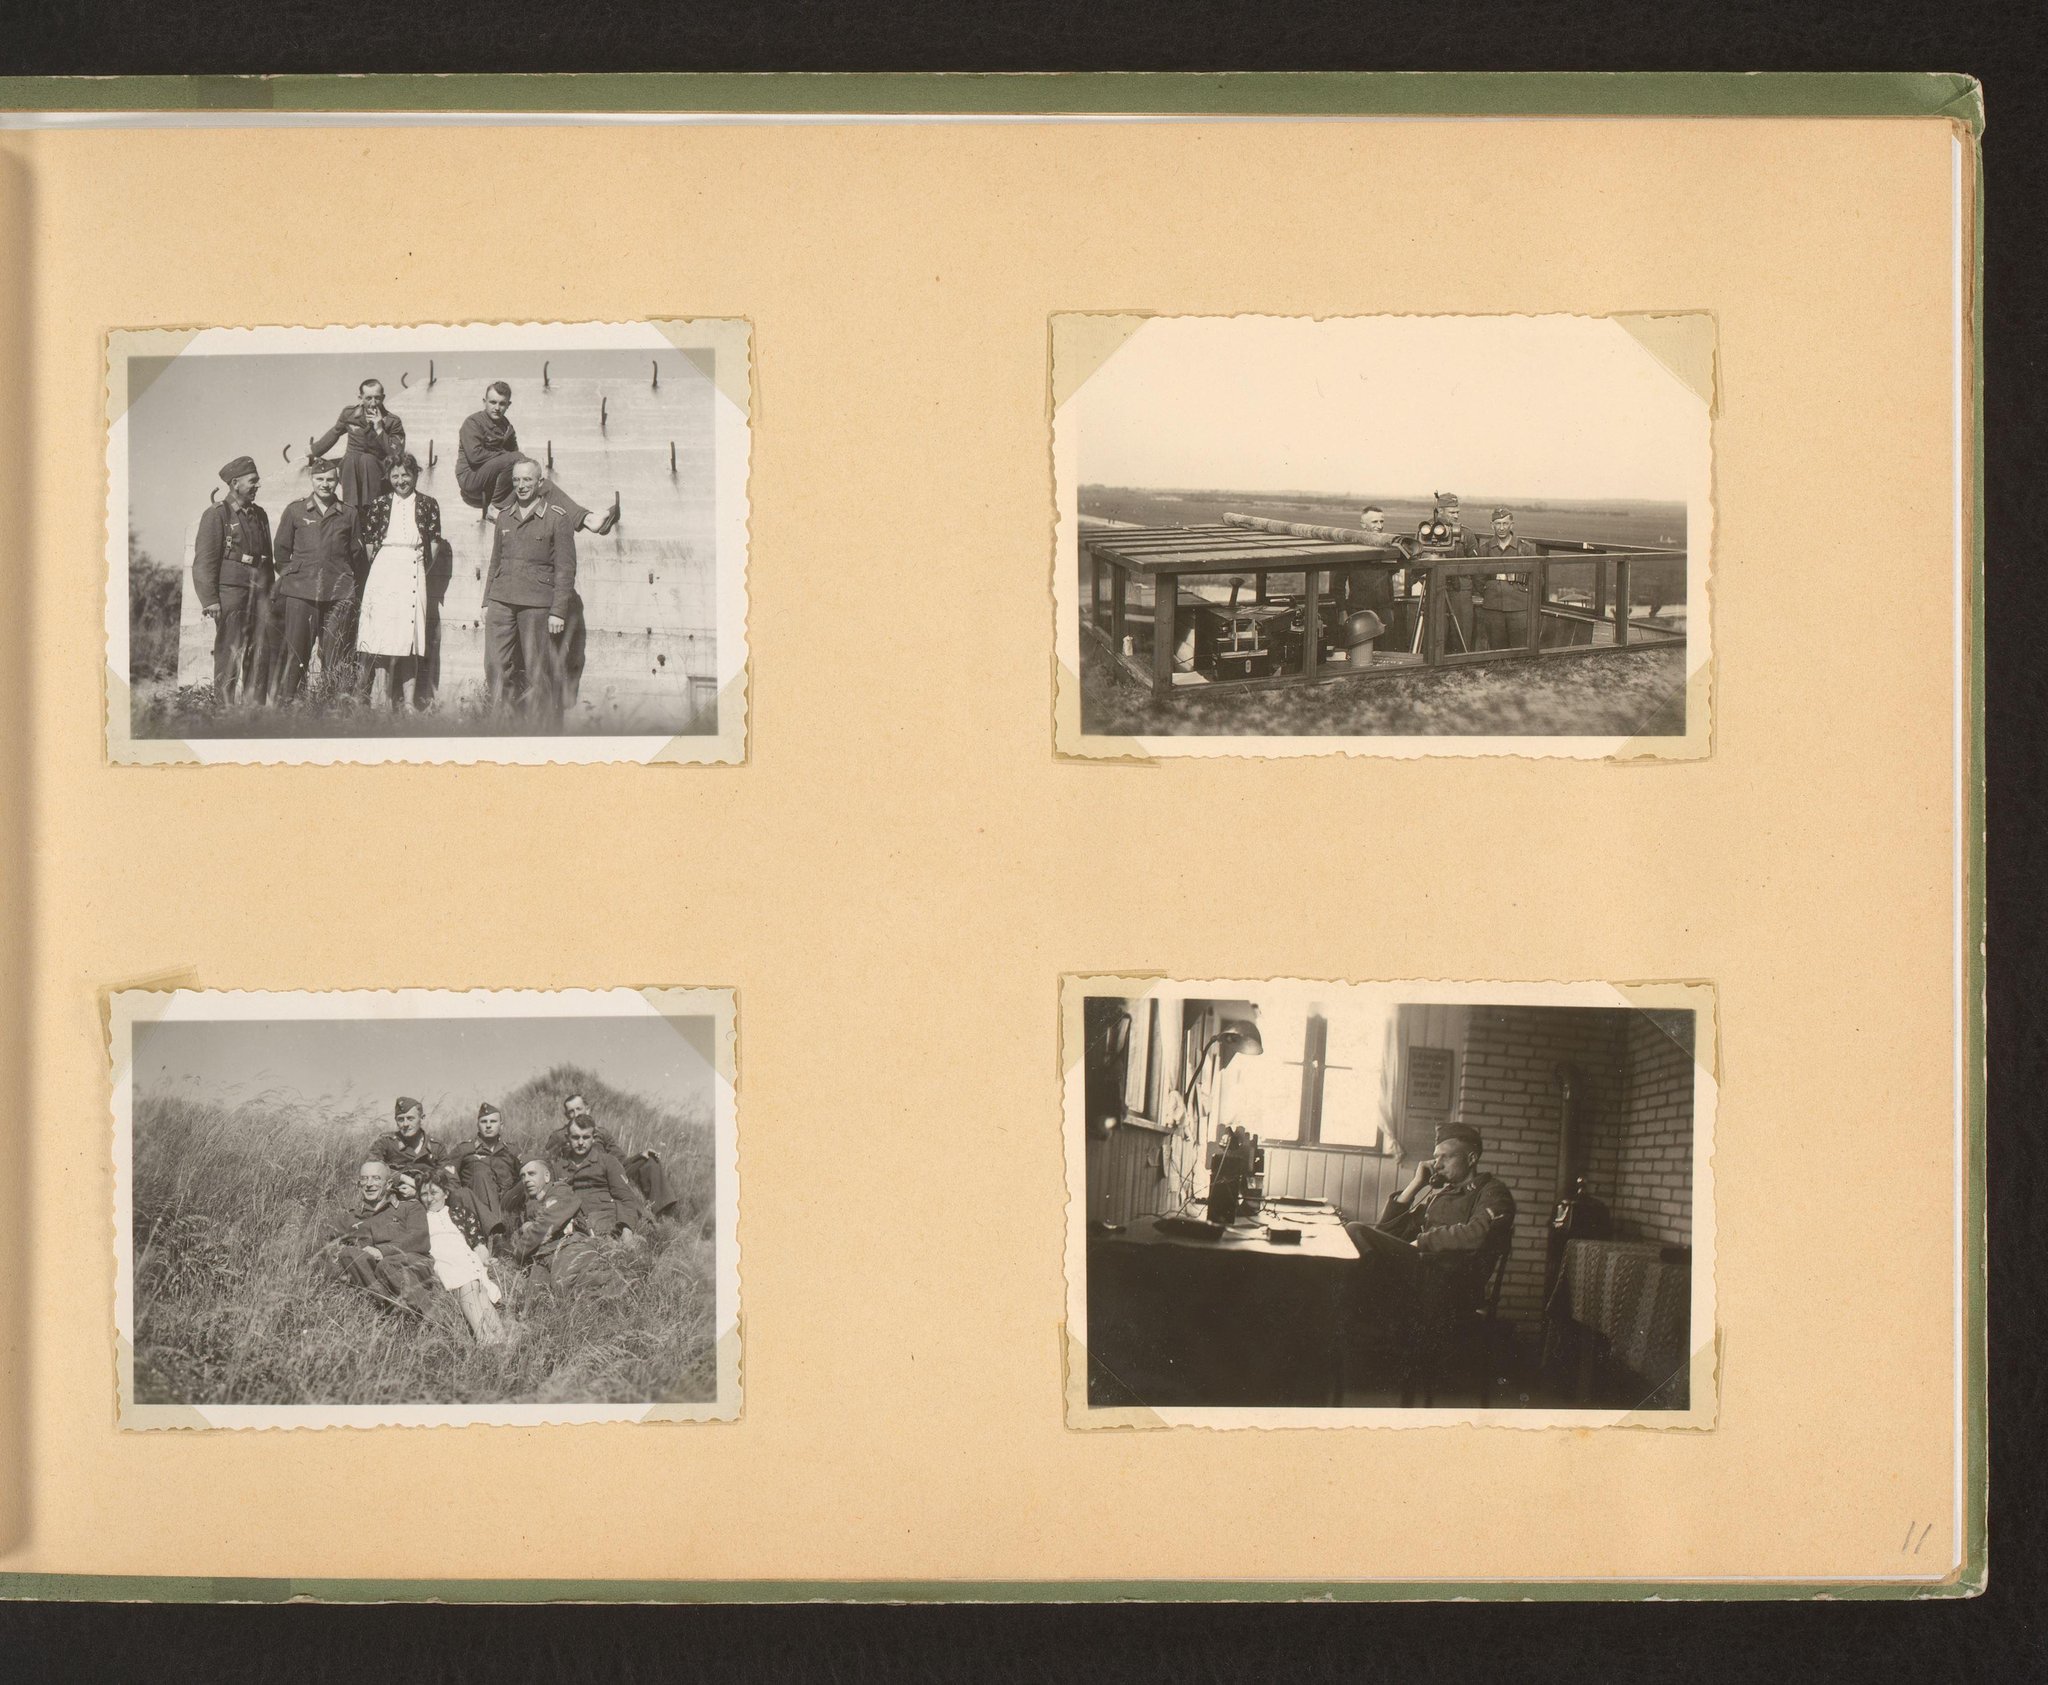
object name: photograph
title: Groep Duitse militairen in en op de bunker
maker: Anonymous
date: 1940-1944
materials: paper, photographic support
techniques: gelatin silver print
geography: netherlands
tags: occupier and civilians, dune coast, the company, the unit, the troop ~ military service, permanent fortifications, netherlands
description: Albumblad met vier foto´s van Duitse militairen in en op een bunker aan de Nederlandse kust. Op twee foto's staat een (Nederlandse?) vrouw tussen de militairen. Onderdeel van het fotoalbum Bewaking bunkers.